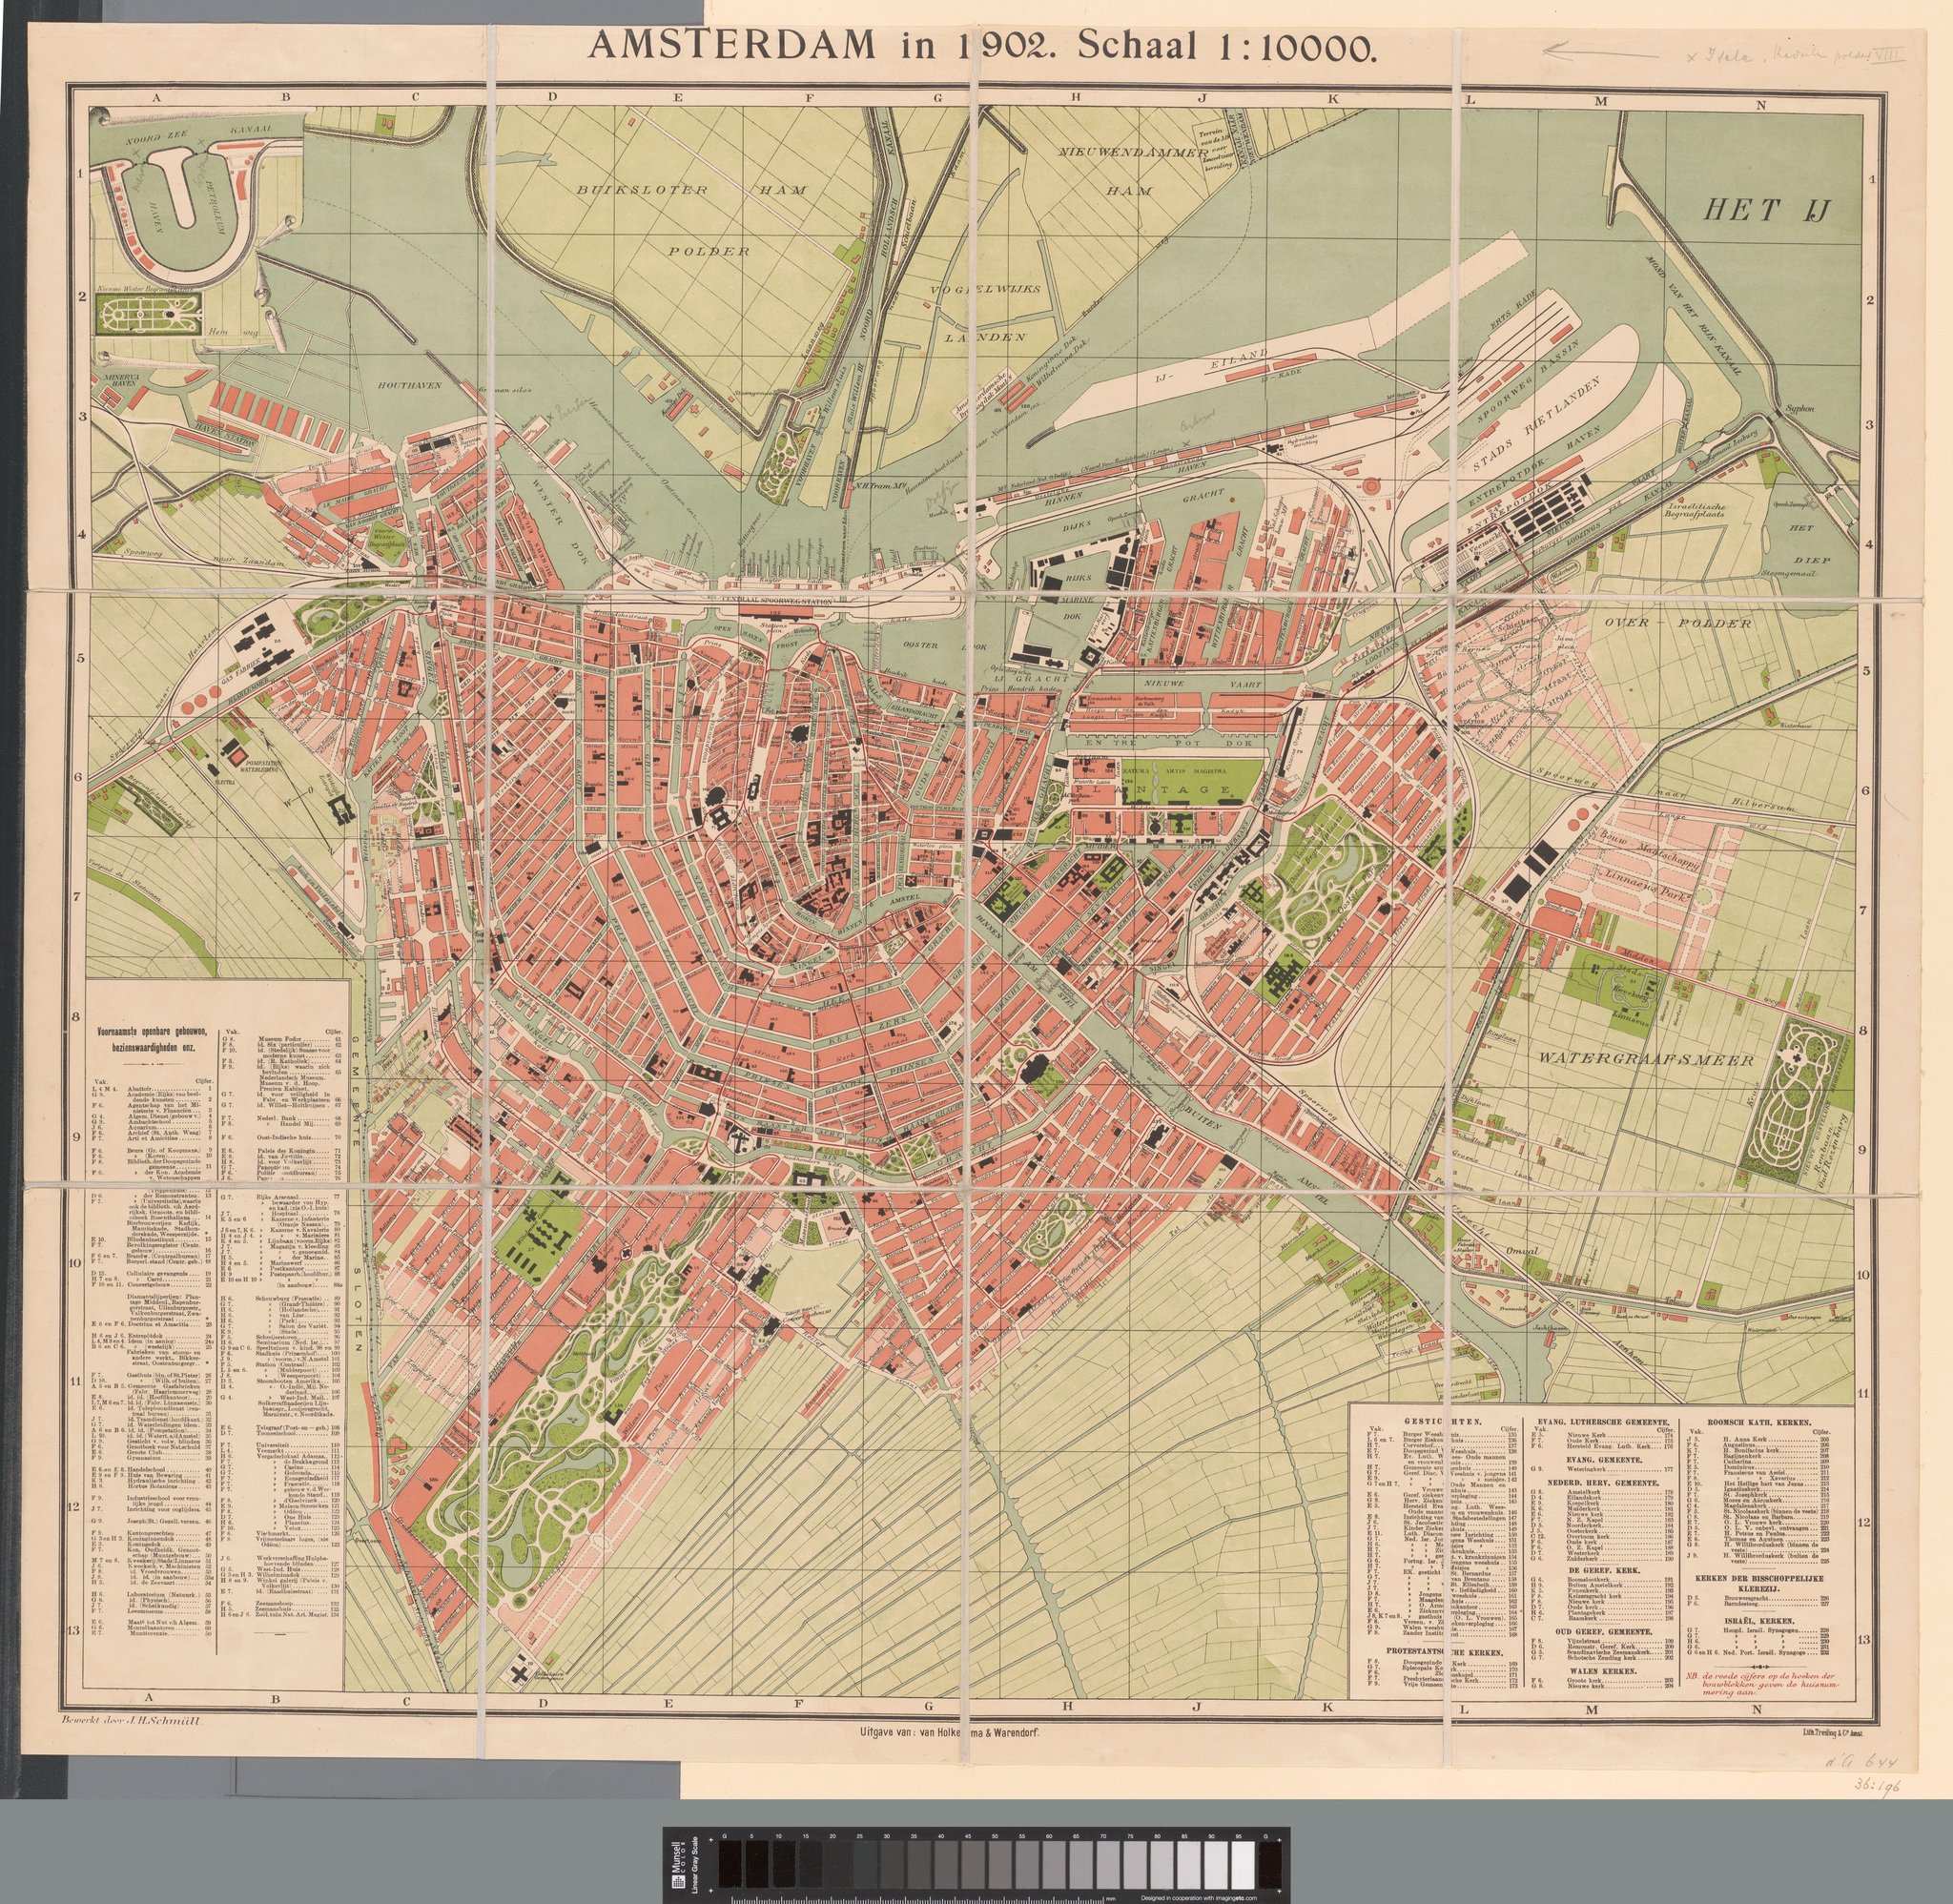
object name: area plan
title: Plattegrond van Amsterdam, 1902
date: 1902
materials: linen, paper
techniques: lithograph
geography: amsterdam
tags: maps of cities, amsterdam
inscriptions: collector's mark: Lugt 2228